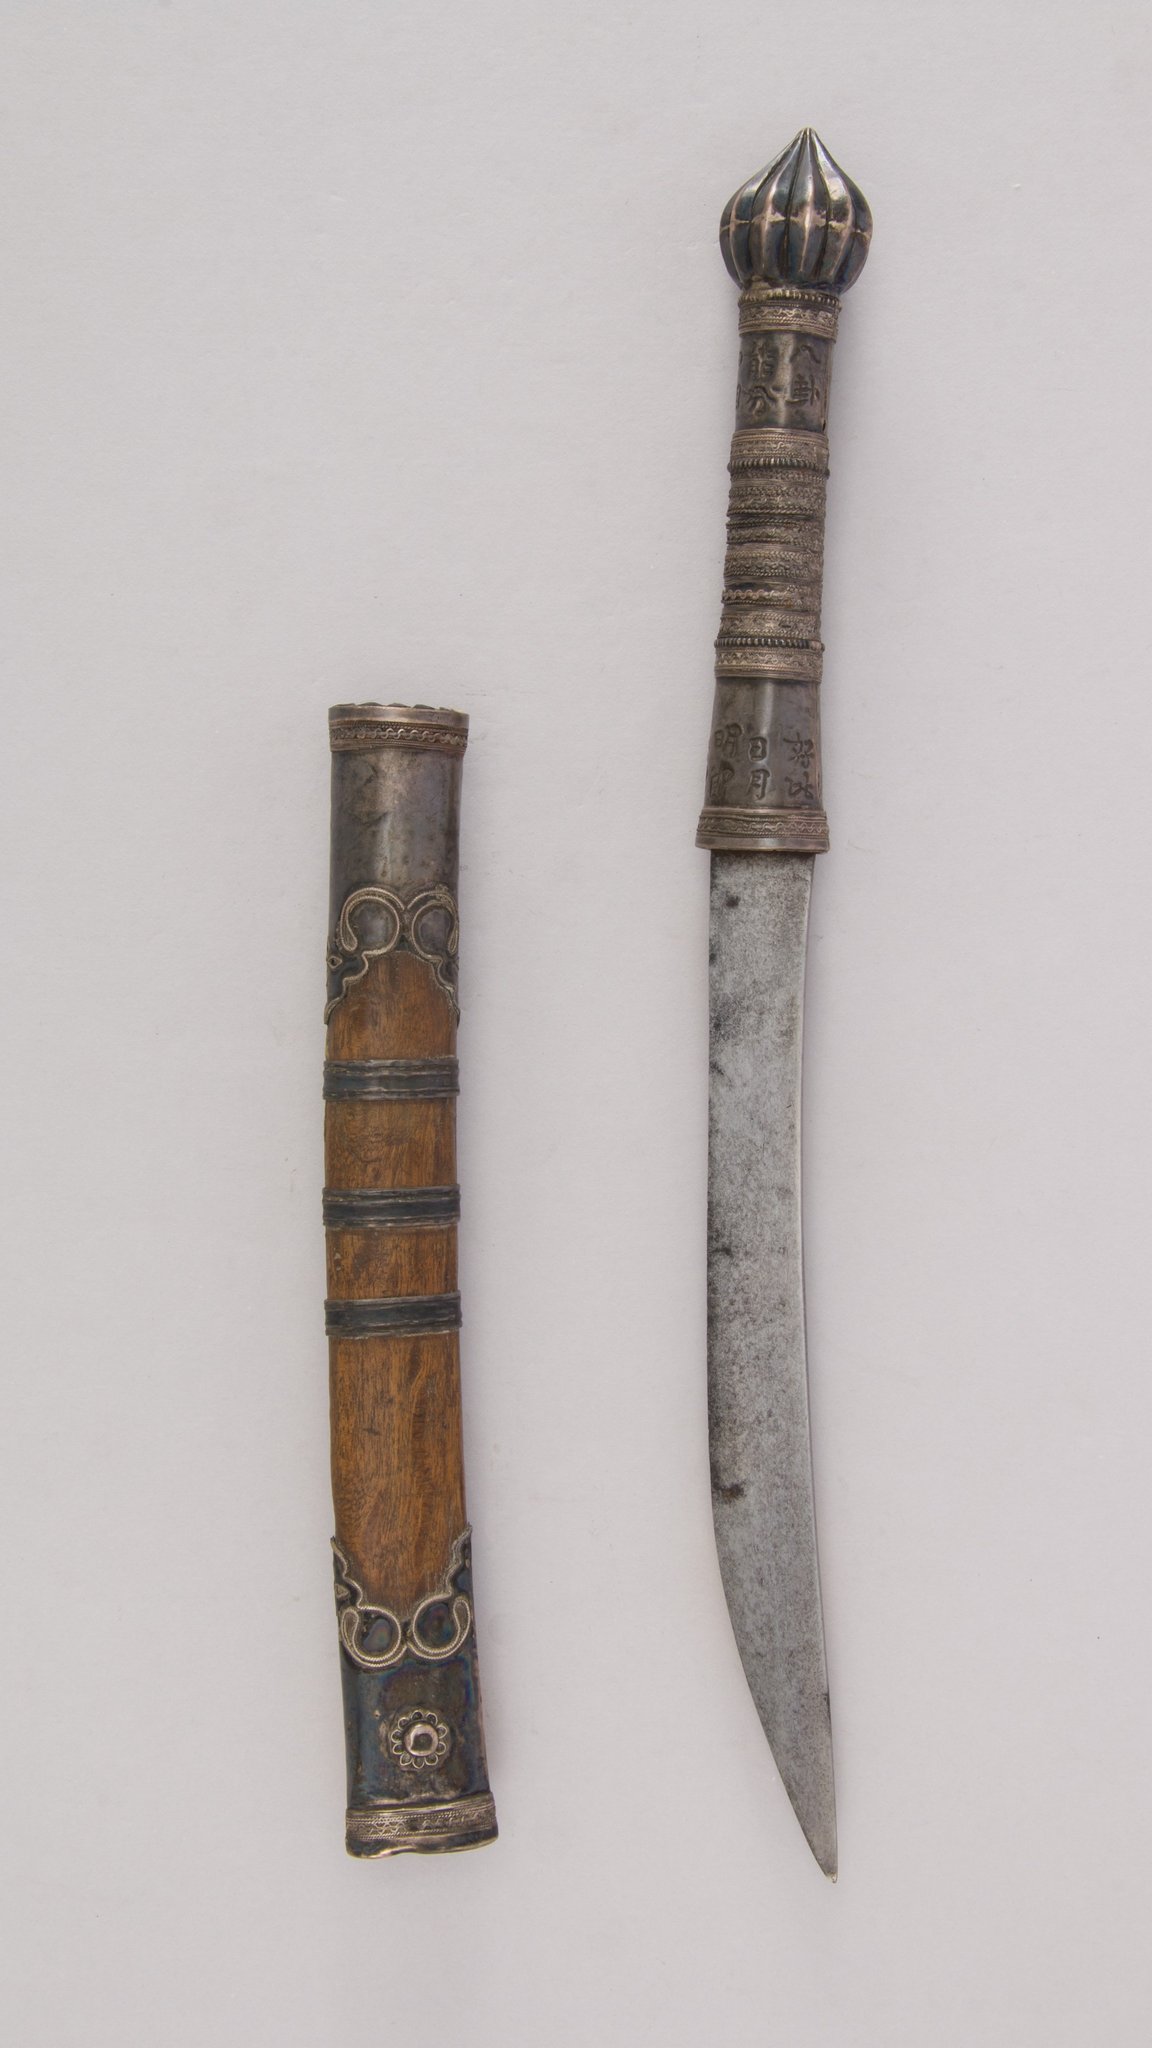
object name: knife dha with sheath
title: Knife (Dha) with Sheath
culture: thai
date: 1701-1900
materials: silver, steel, wood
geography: thailand